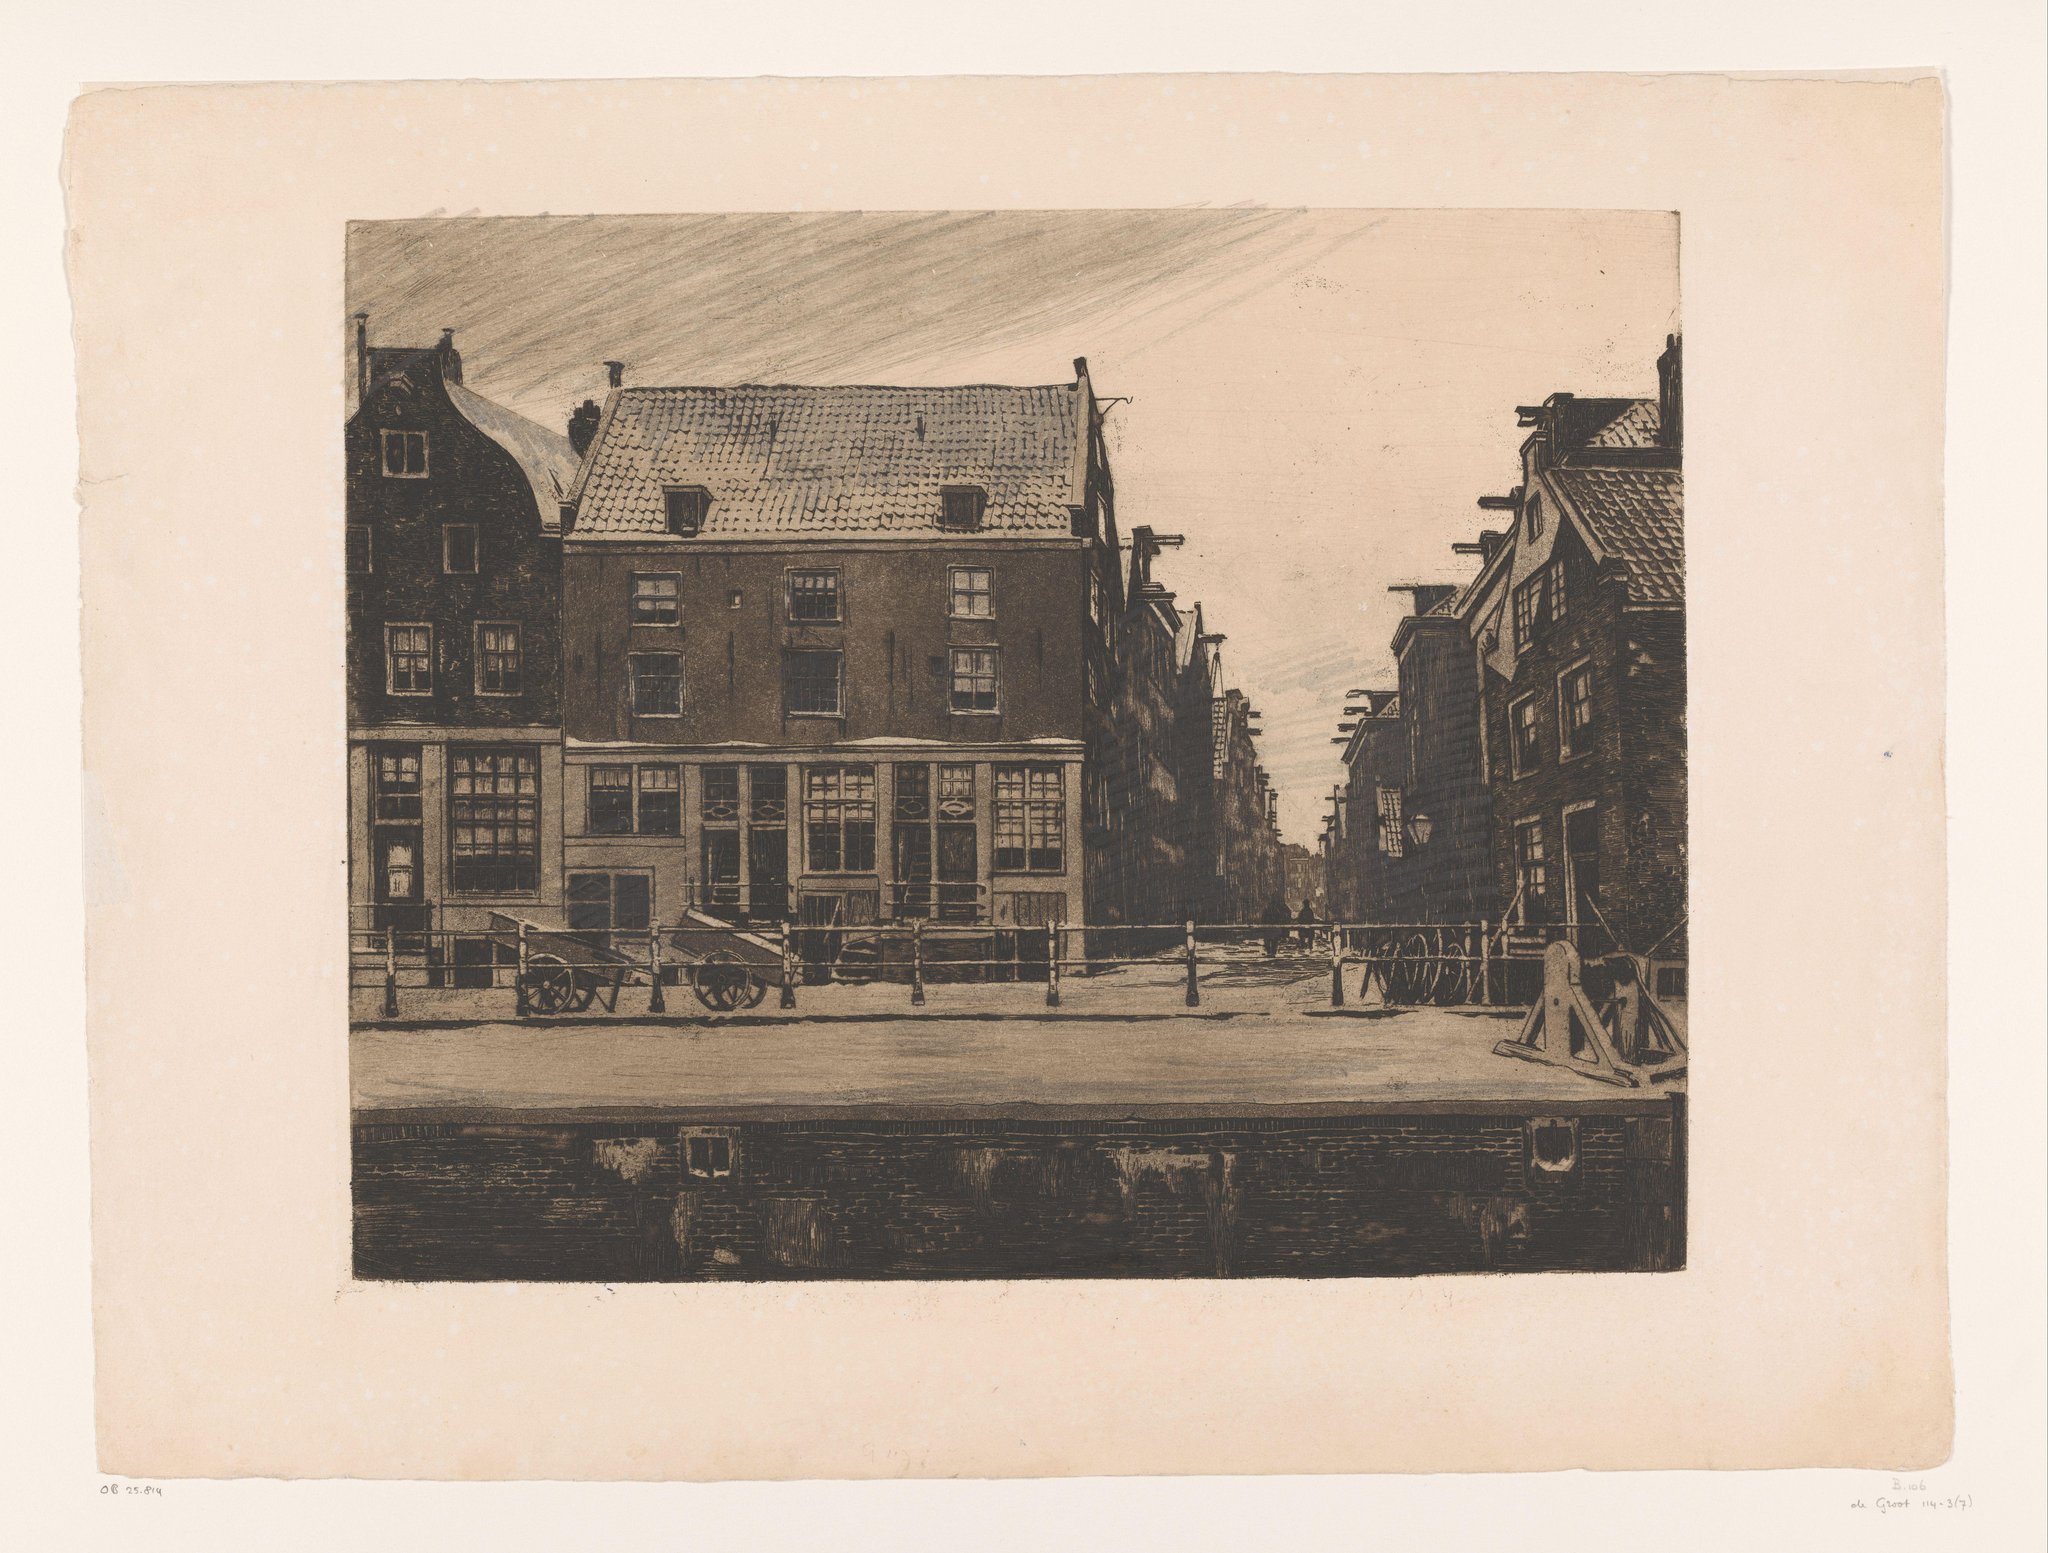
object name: print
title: Jodenhouttuinen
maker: willem witsen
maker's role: draughtsman, painter, print maker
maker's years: 1860-1923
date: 1906-1907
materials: paper, pencil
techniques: aquatint, etching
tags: urban housing, street, amsterdam